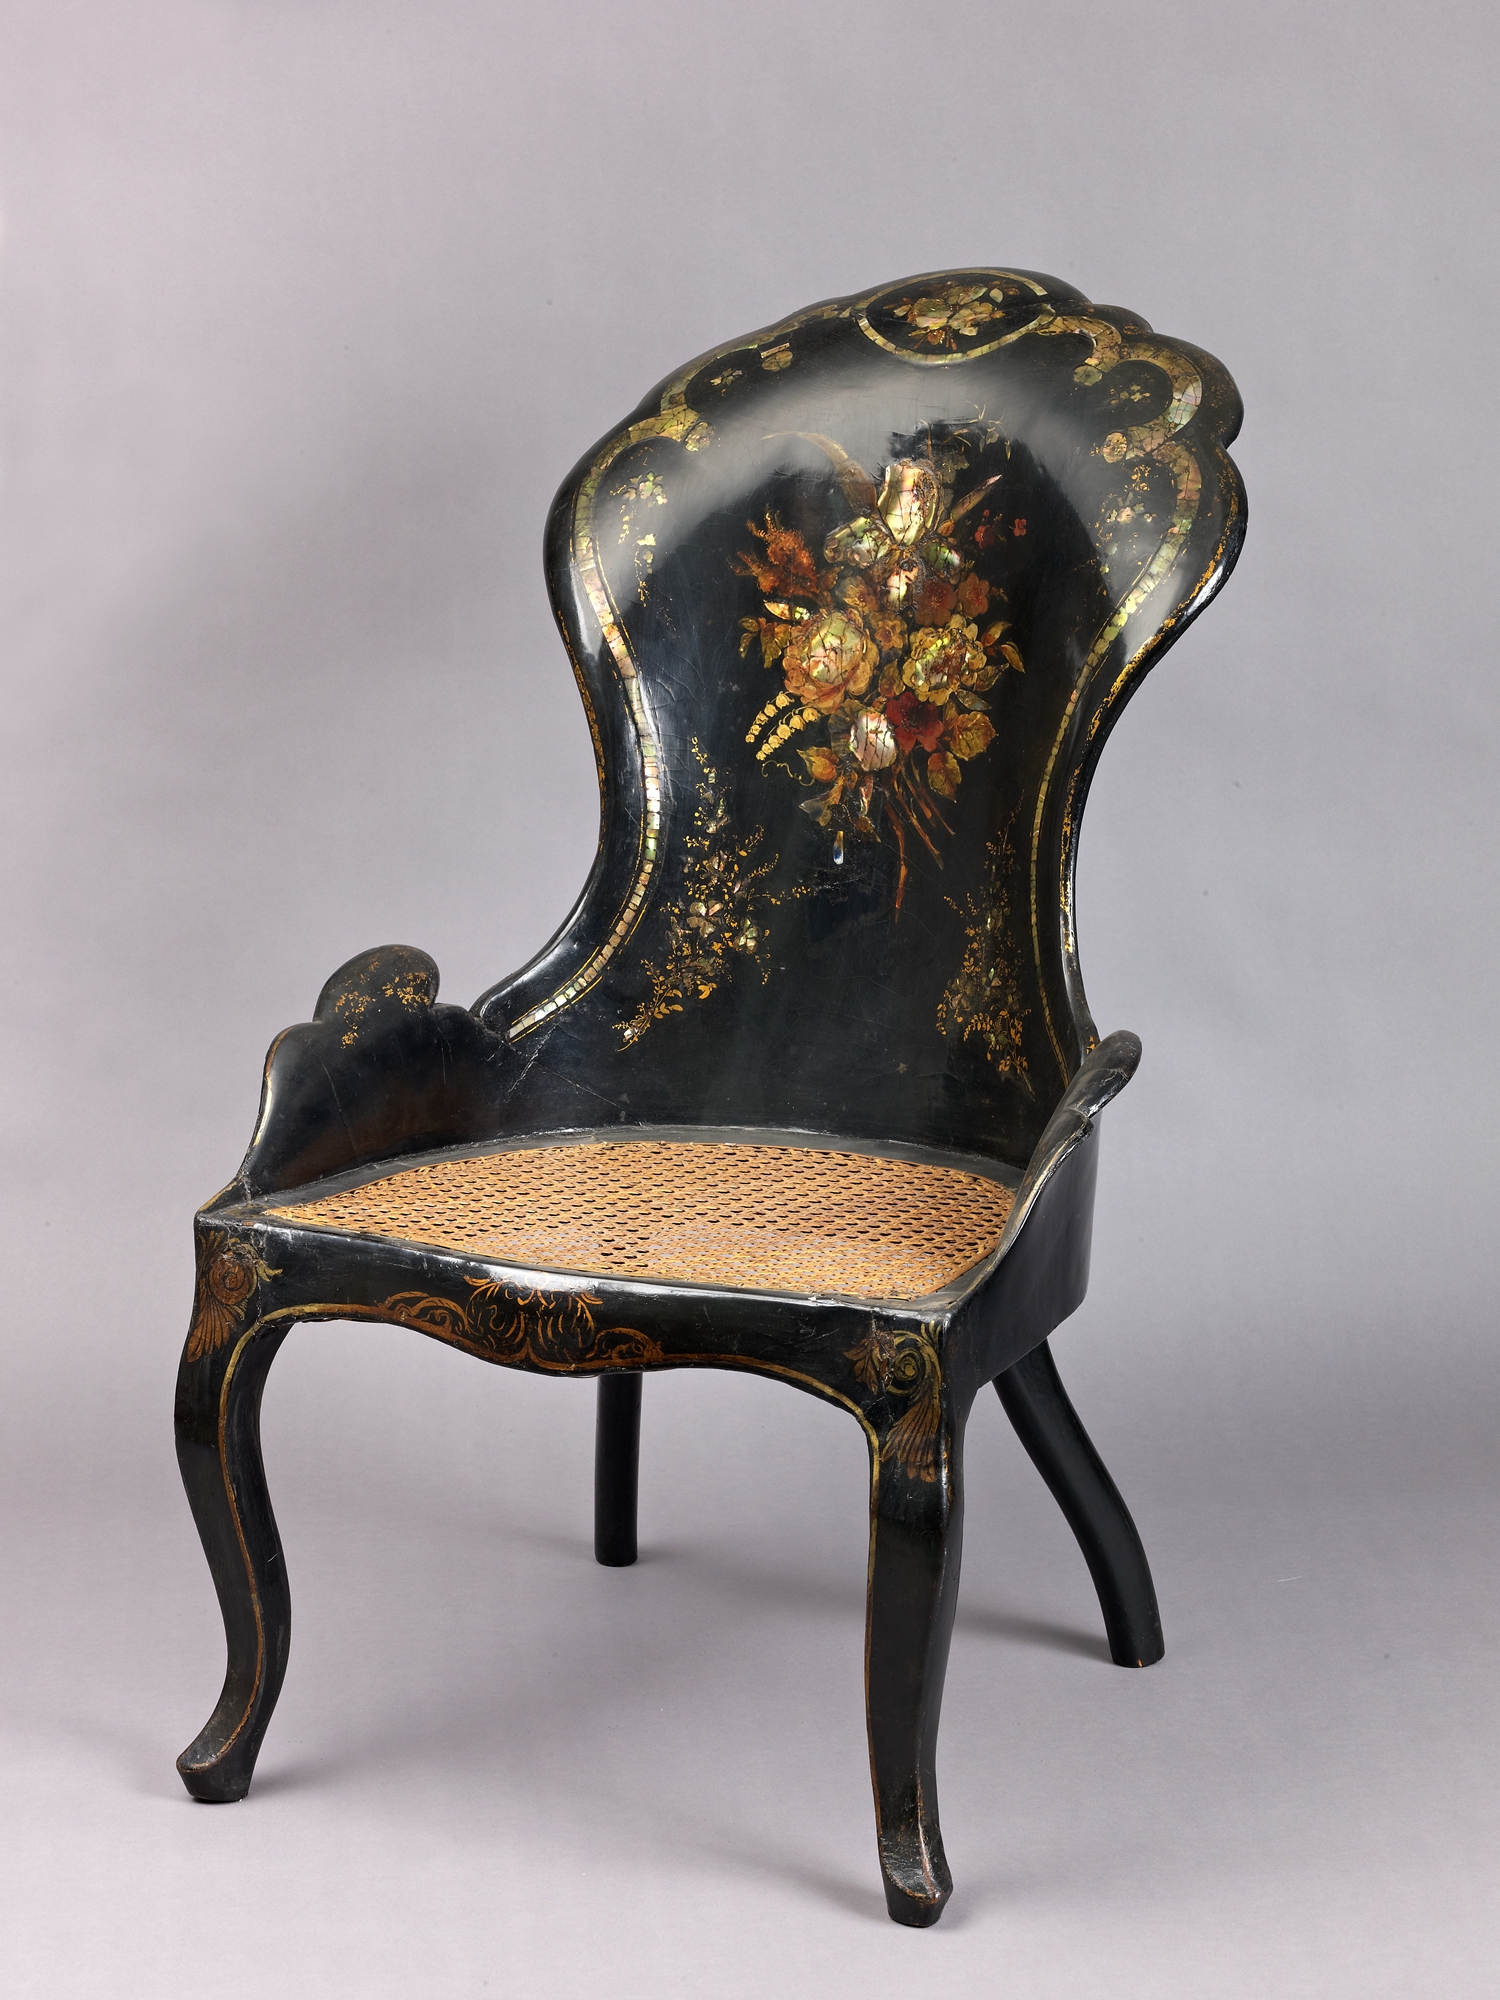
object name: chair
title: Gondola armchair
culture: british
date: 1830-1860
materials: lacquer, mother of pearl, paper, wood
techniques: caning, gilding, painting